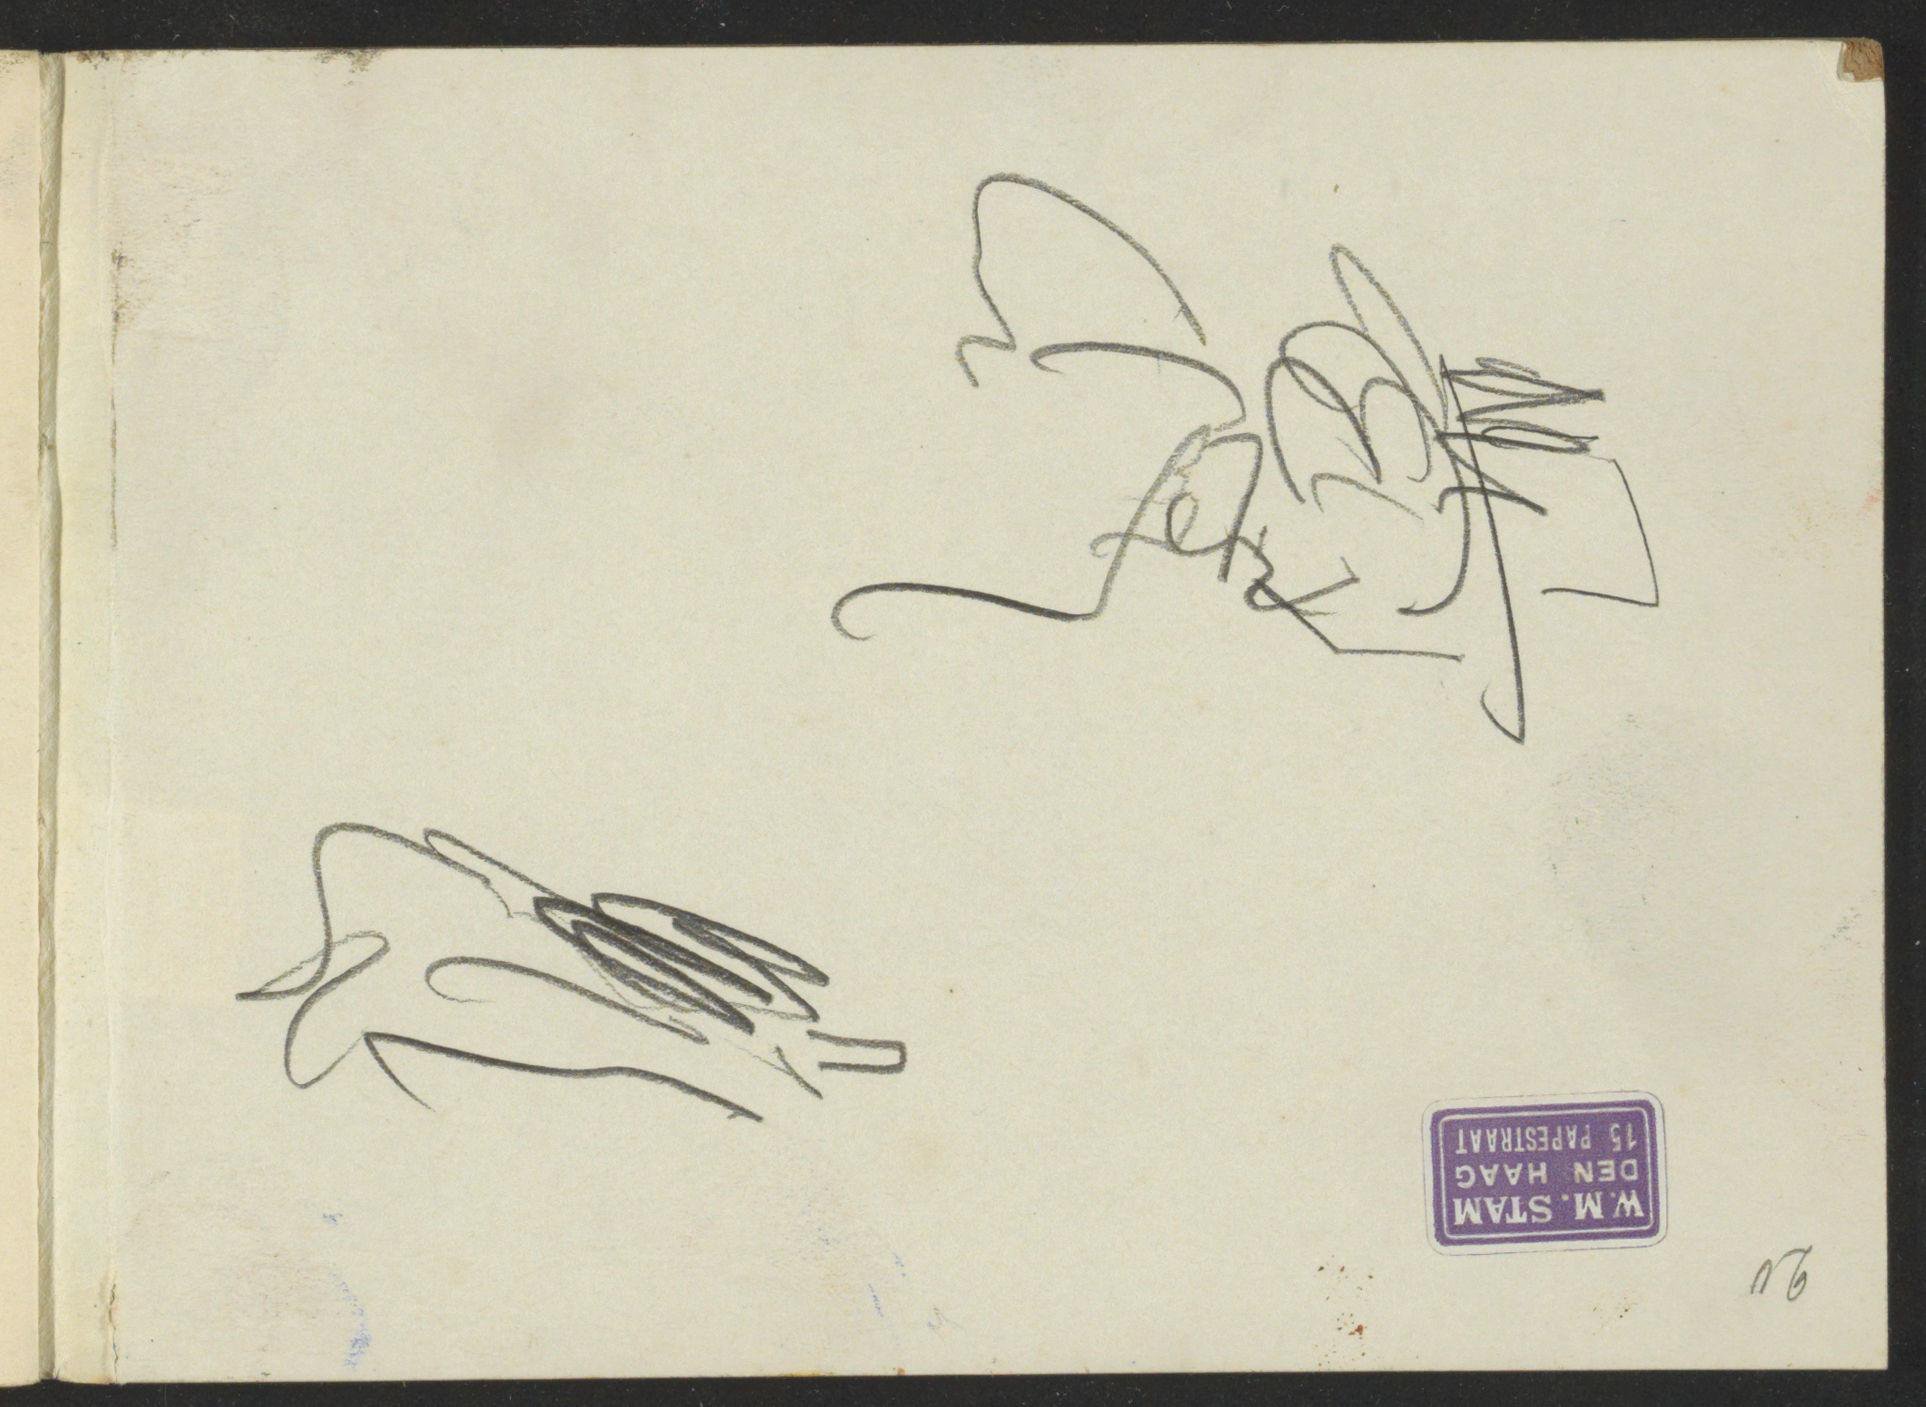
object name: endleaf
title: Vrouw met hoed, in profiel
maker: isaac israels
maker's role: draughtsman, painter, print maker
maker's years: 1865-1934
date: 1875-1934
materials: paper, pencil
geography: the hague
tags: head-gear: hat (+ women's clothes), adult woman (+ sideview, profile)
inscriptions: retailer's mark: ‘W.M. Stam / Den Haag / 15 Papestraat’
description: Schutblad B, achterste schutblad, uit schetsboek LVII met 29 bladen.